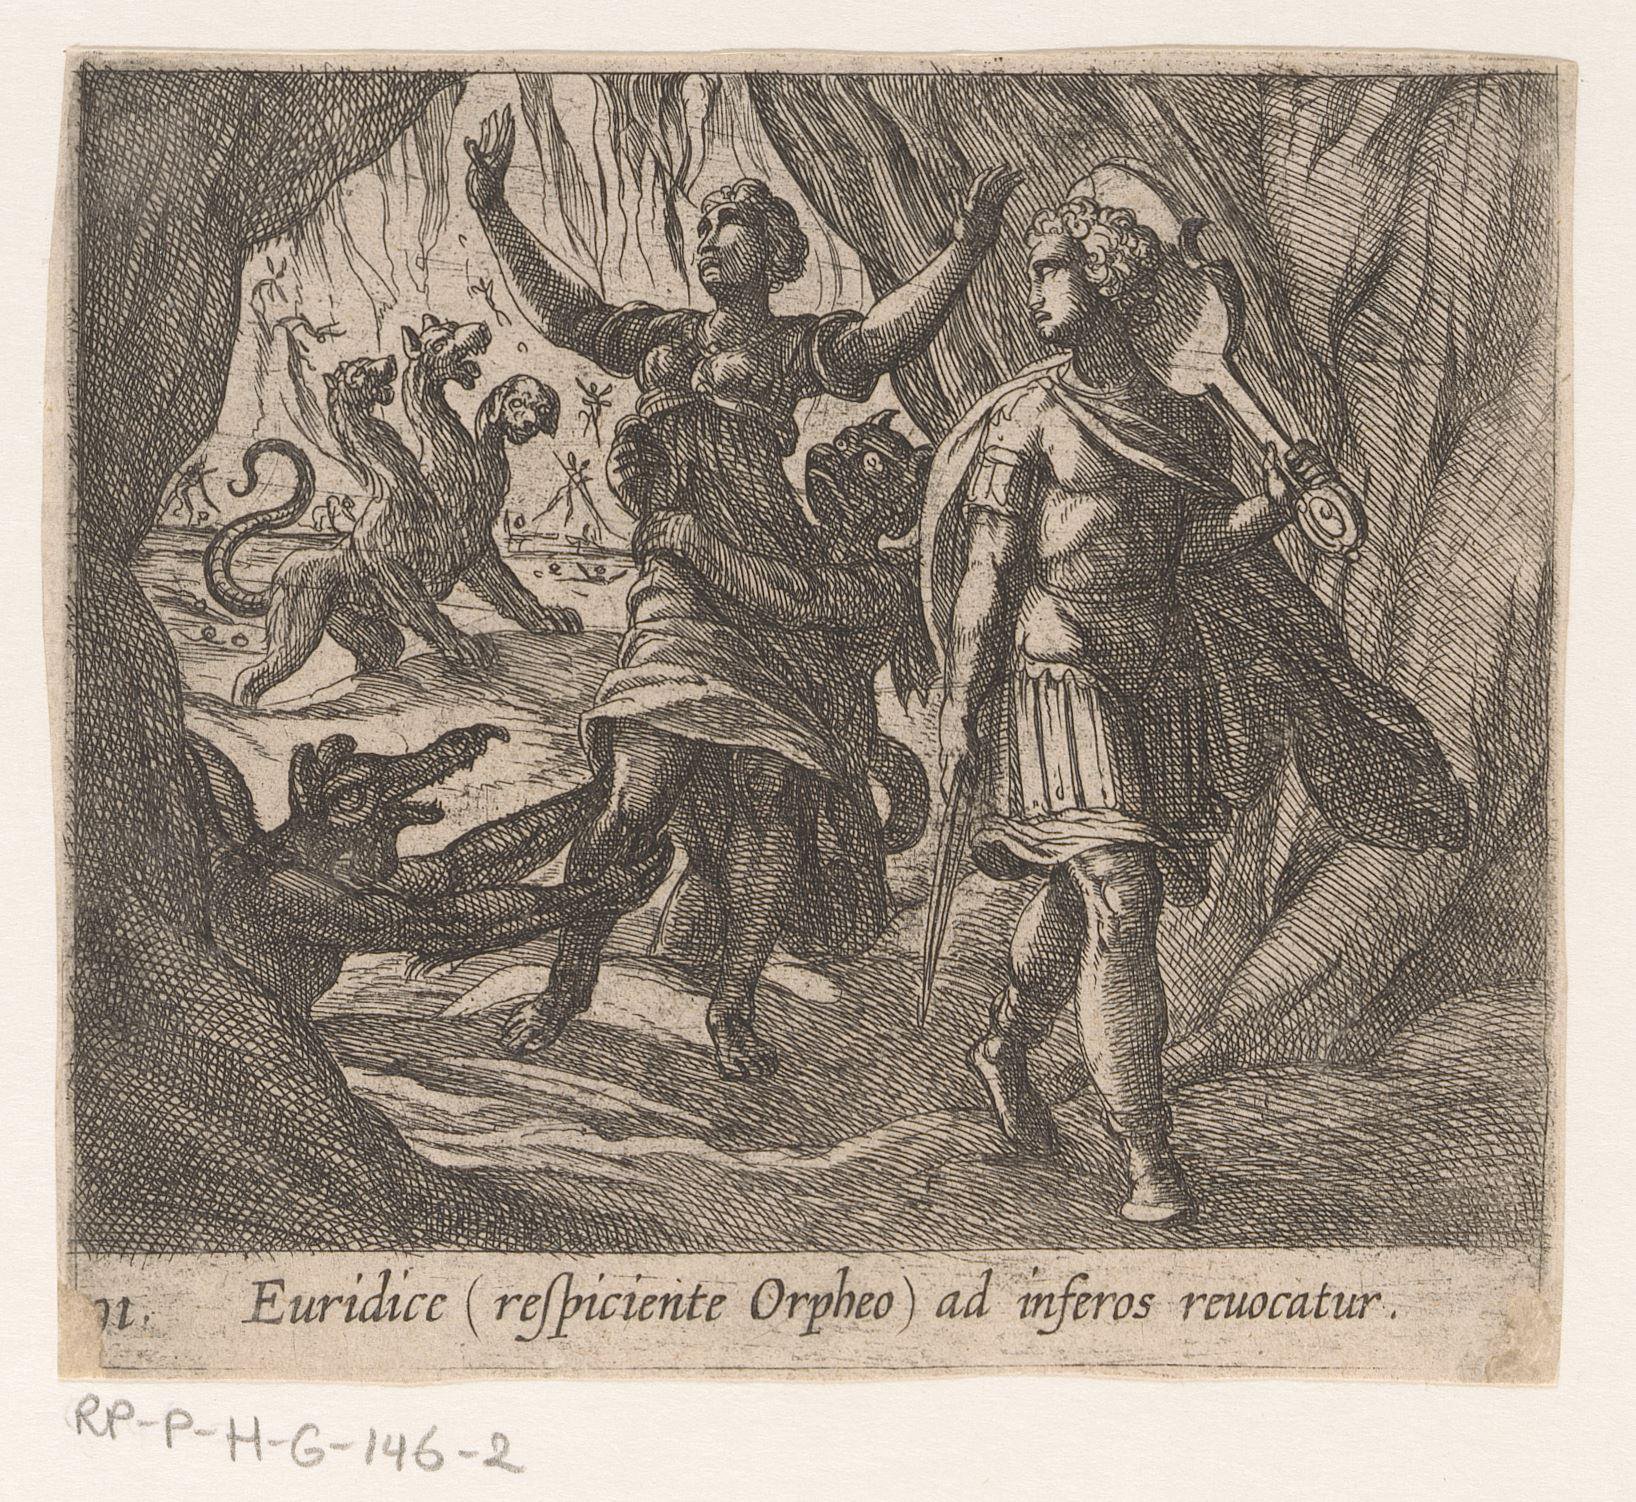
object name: print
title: Metamorfosen van Ovidius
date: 1606-1638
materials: paper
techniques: etching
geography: amsterdam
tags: orpheus and eurydice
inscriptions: collector's mark: ‘Hinloopen’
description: Duivelse wezens uit de Hades grijpen Eurydice, omdat Orpheus heeft omgekeken. Op de achtergrond staat Cerberus. Titel in het Latijn in ondermarge.